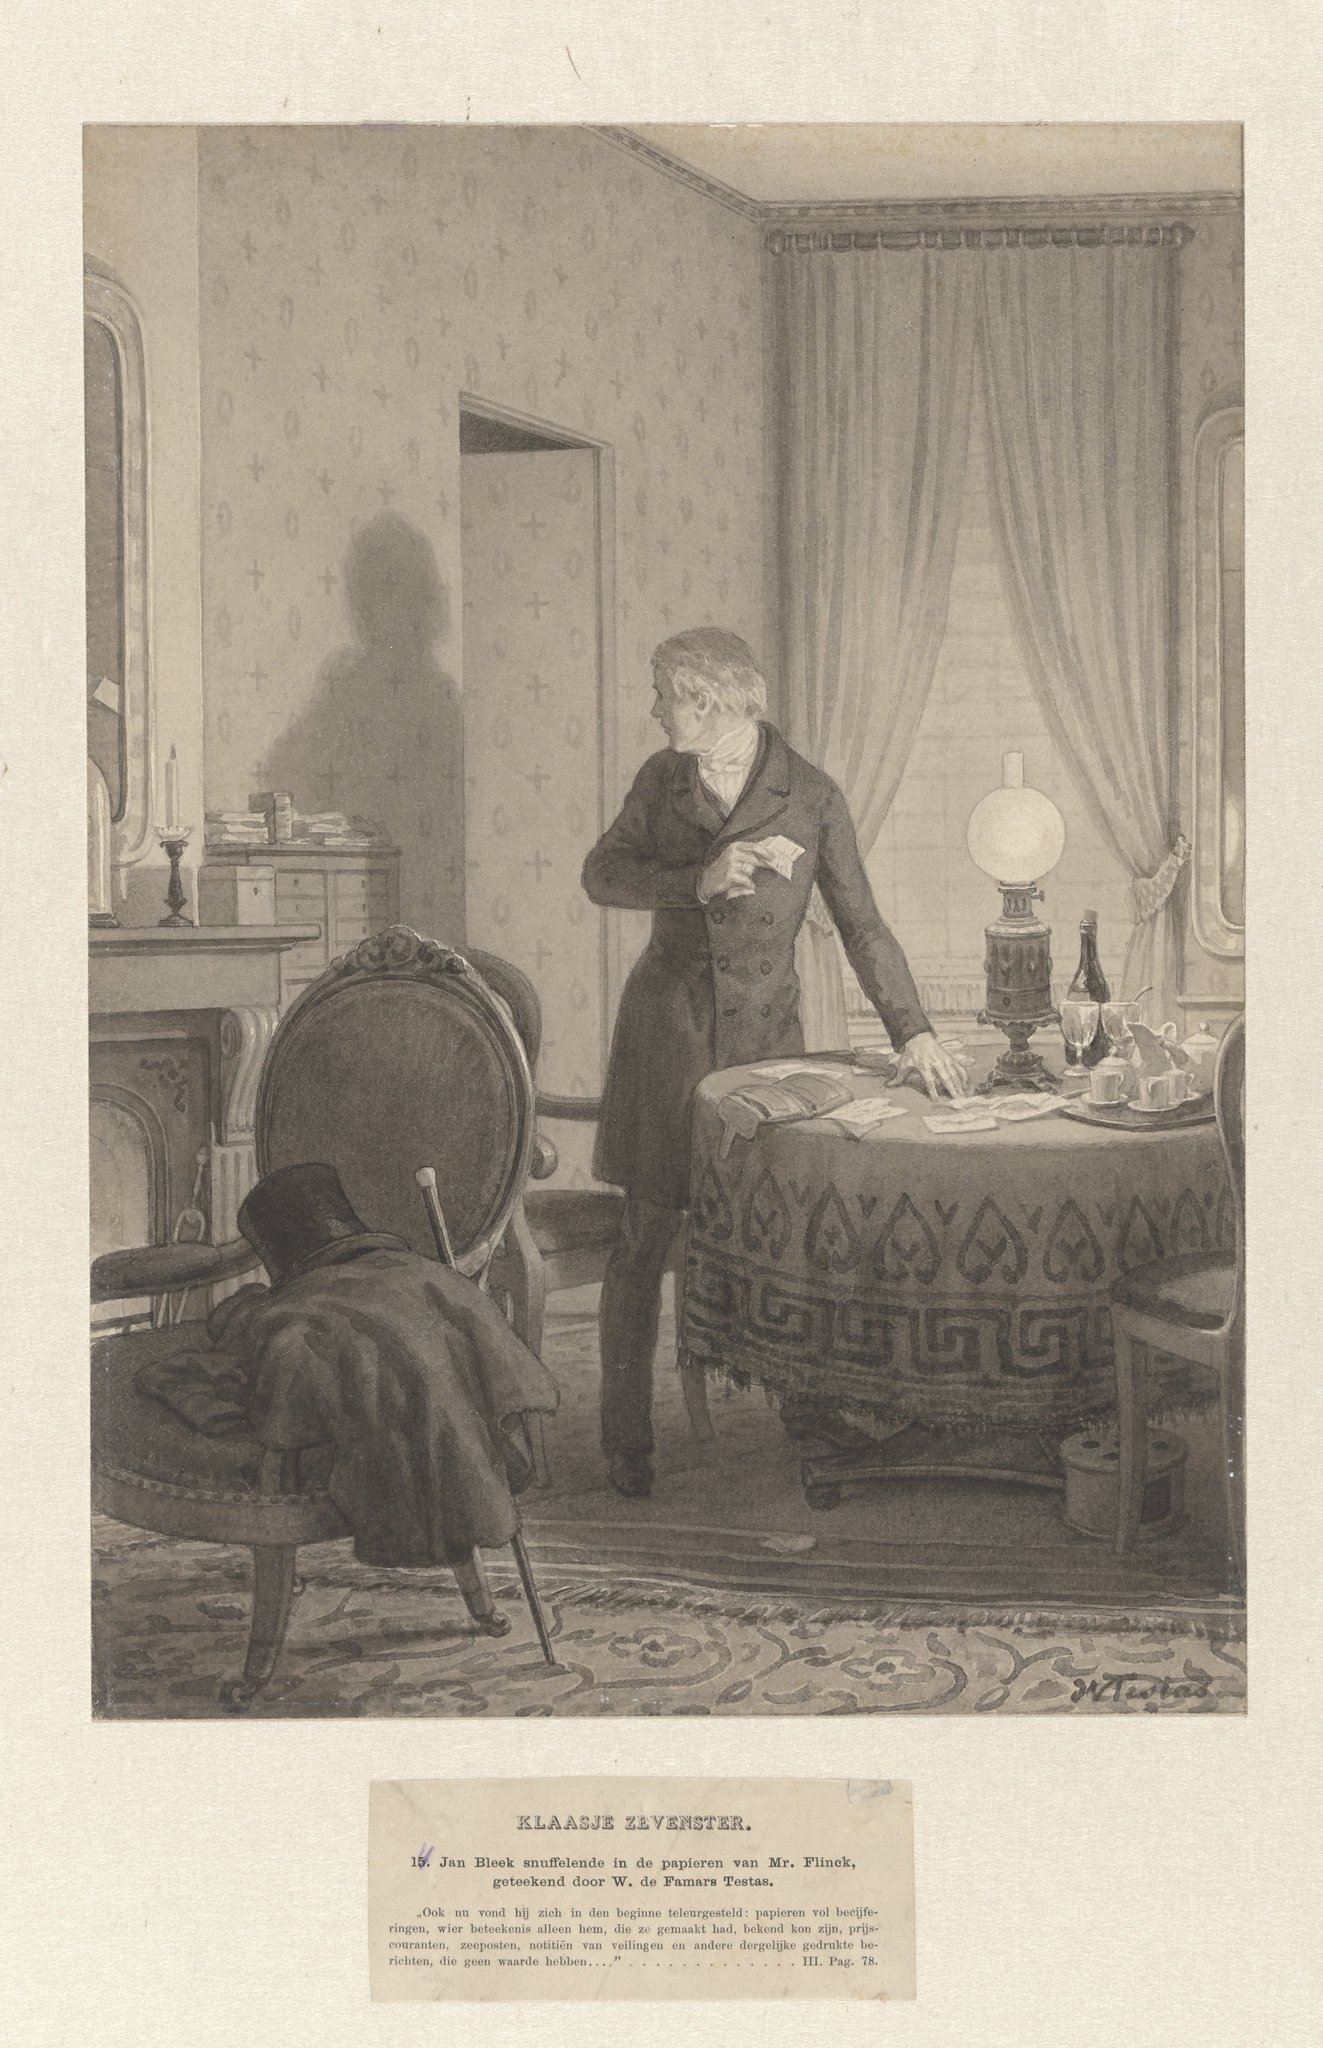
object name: drawing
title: Jan Bleek snuffelende in de papieren van Mr. Flinck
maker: willem de famars testas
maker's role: draughtsman, painter, print maker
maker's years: 1834-1896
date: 1888-1890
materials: paper, pencil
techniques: brush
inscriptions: inscription: ‘...en geannoteerd met de geillustreerde passage uit Van Lennep’, signature and date: ‘W. de Famars Testas-1888-...’, signature: ‘W.Testas’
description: Ontwerp voor een boekillustratie in J. van Lenneps 'Klaasje Zevenster', uitg. A.W. Sijthoff, Leiden (ca. 1888-'90), tegenover pag. 76.